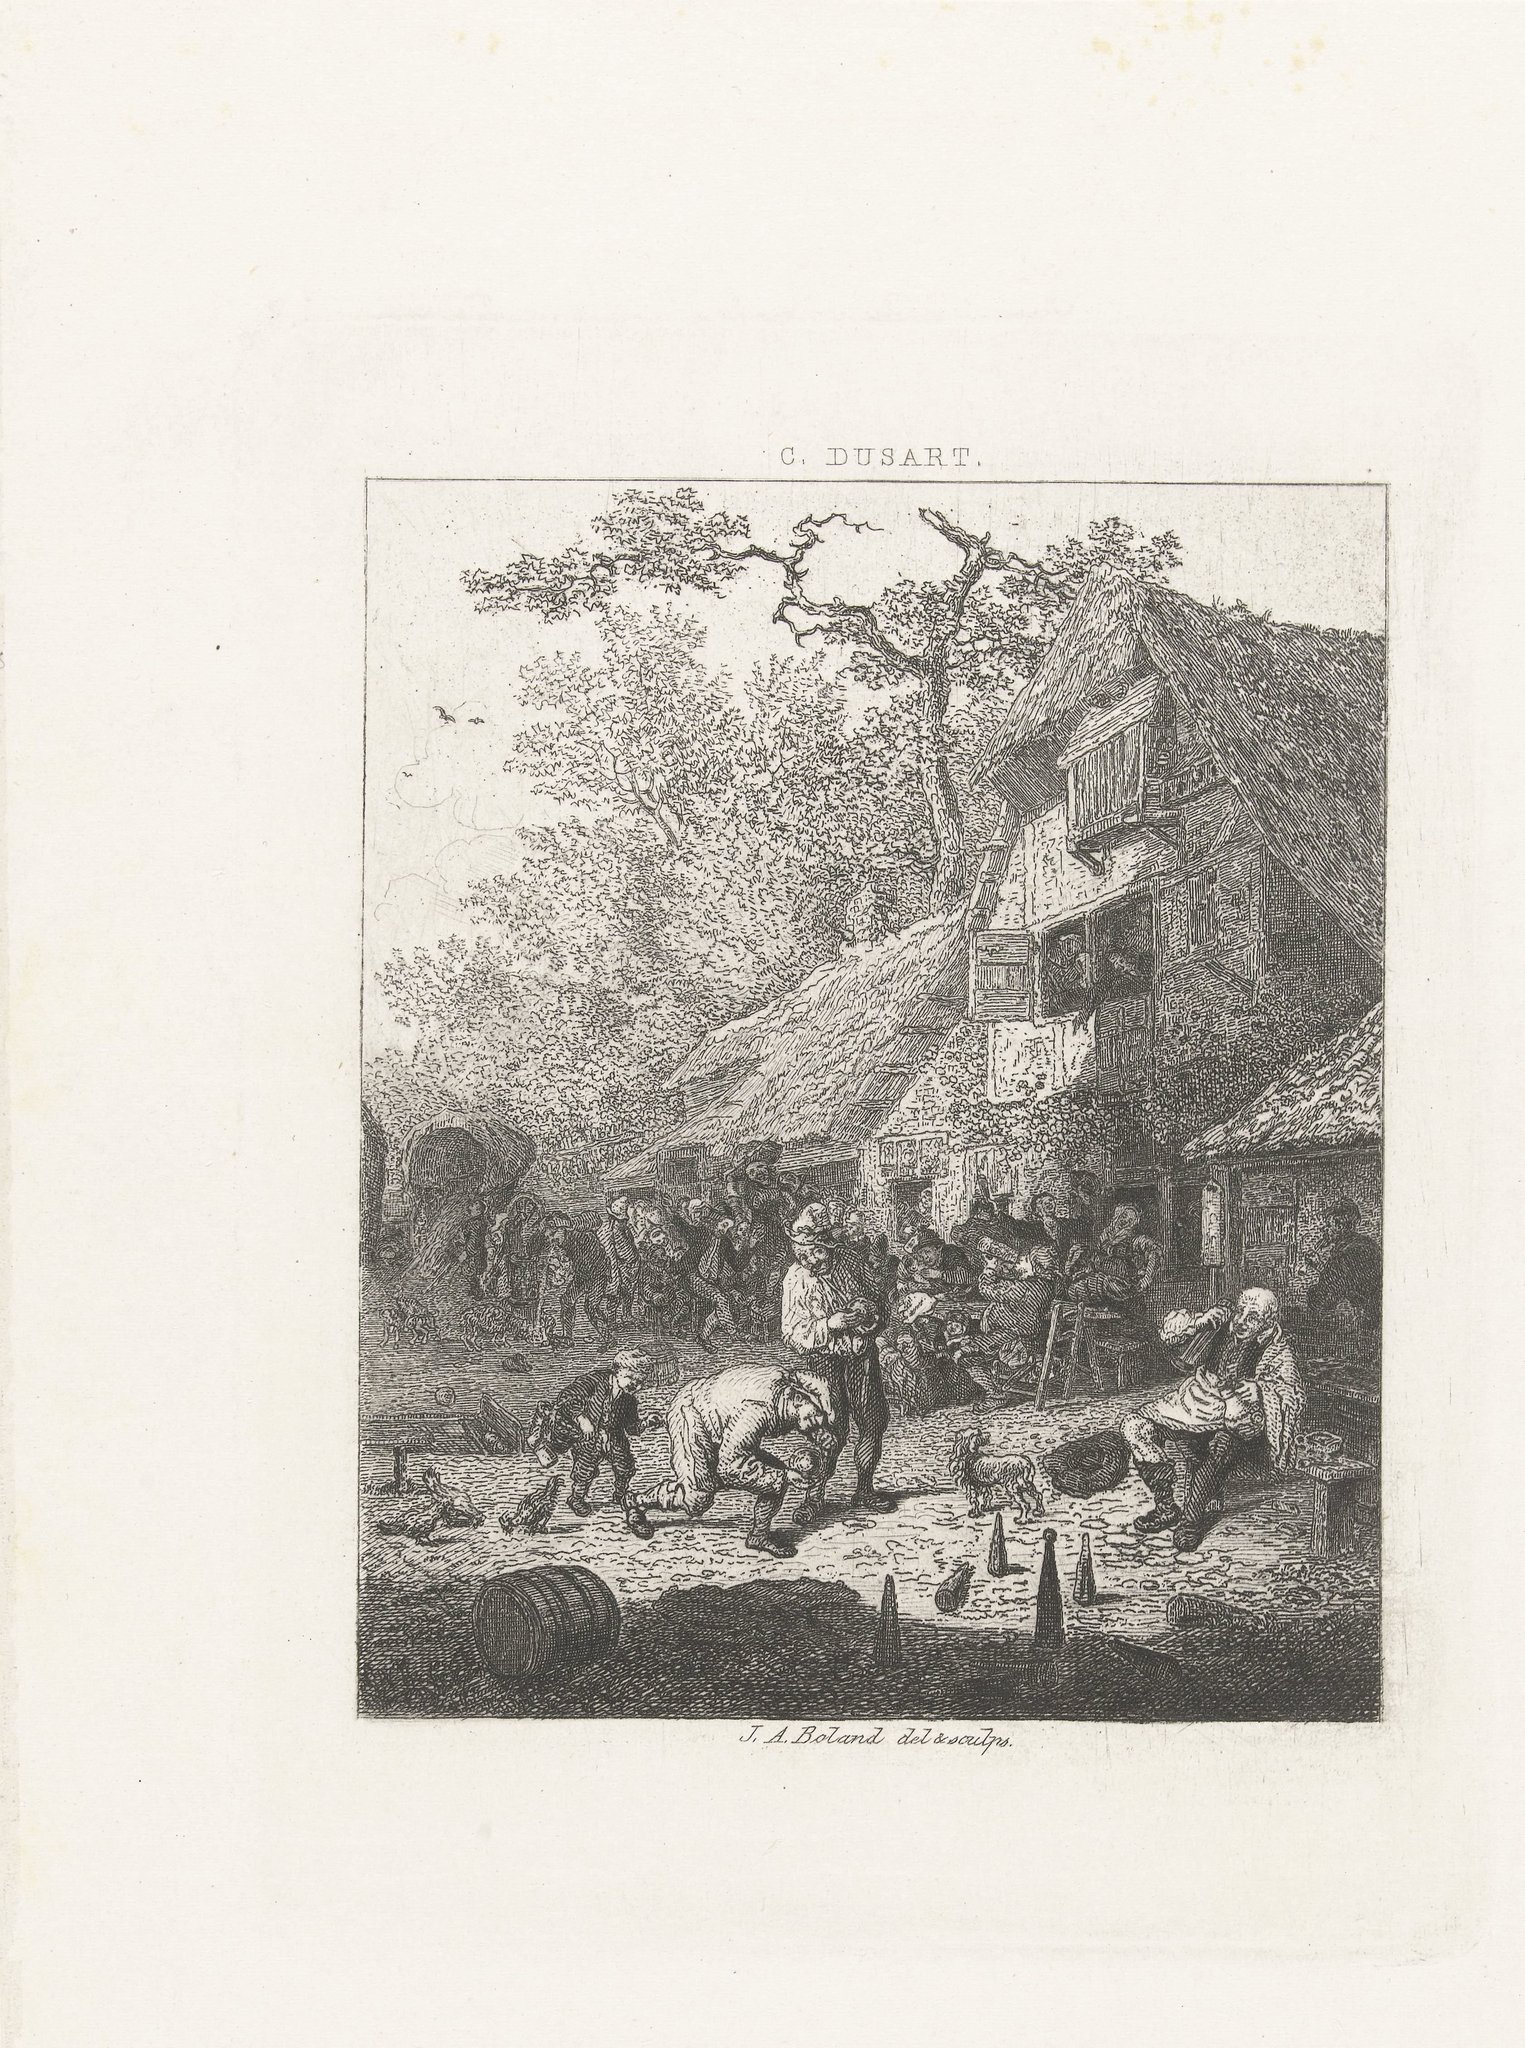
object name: print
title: Kegelaars voor een herberg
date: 1860-1900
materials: paper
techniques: etching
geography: amsterdam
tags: ninepins, skittles (+ out of doors (sports, games, etc.))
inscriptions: collector's mark: Lugt 2228